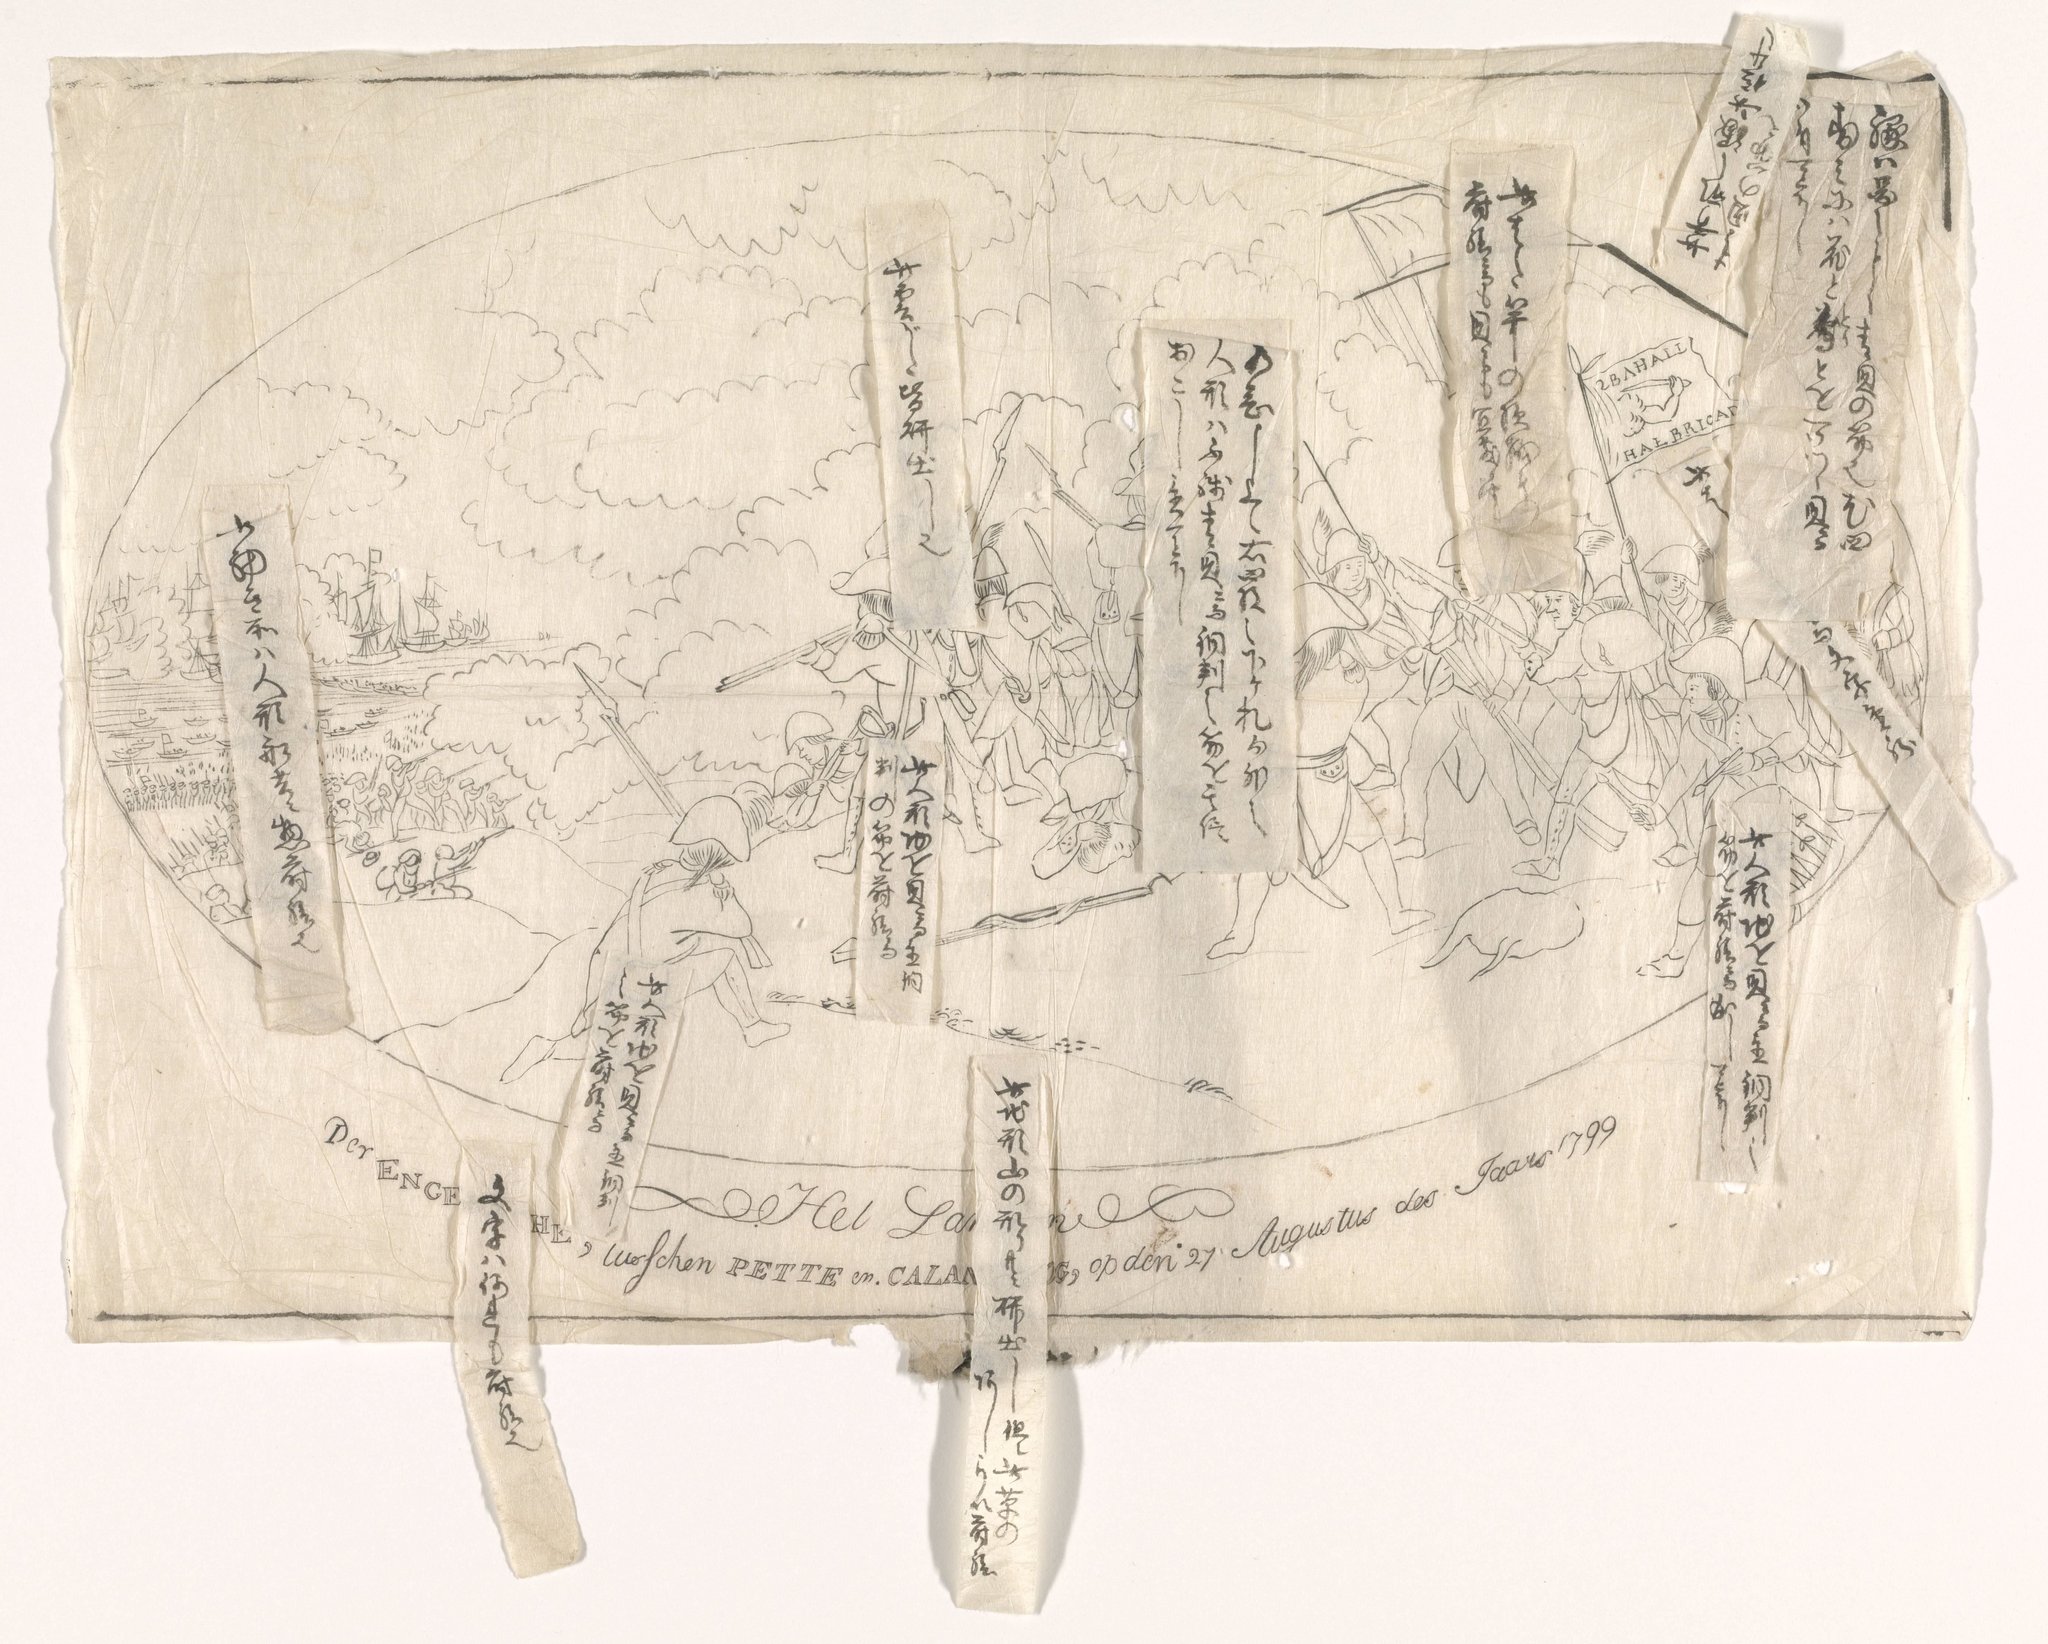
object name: design drawing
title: De landing van de Engelsen tussen Petten en Callantsoog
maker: sasaya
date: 1800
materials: ink, paint, paper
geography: kyoto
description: Ontwerptekening voor een paneel van lakwerk in een sécretaire (NG-401). Op de tekening zitten twaalf aangehechte strips met daarop aanwijzingen in het Japans voor de lakwerker.